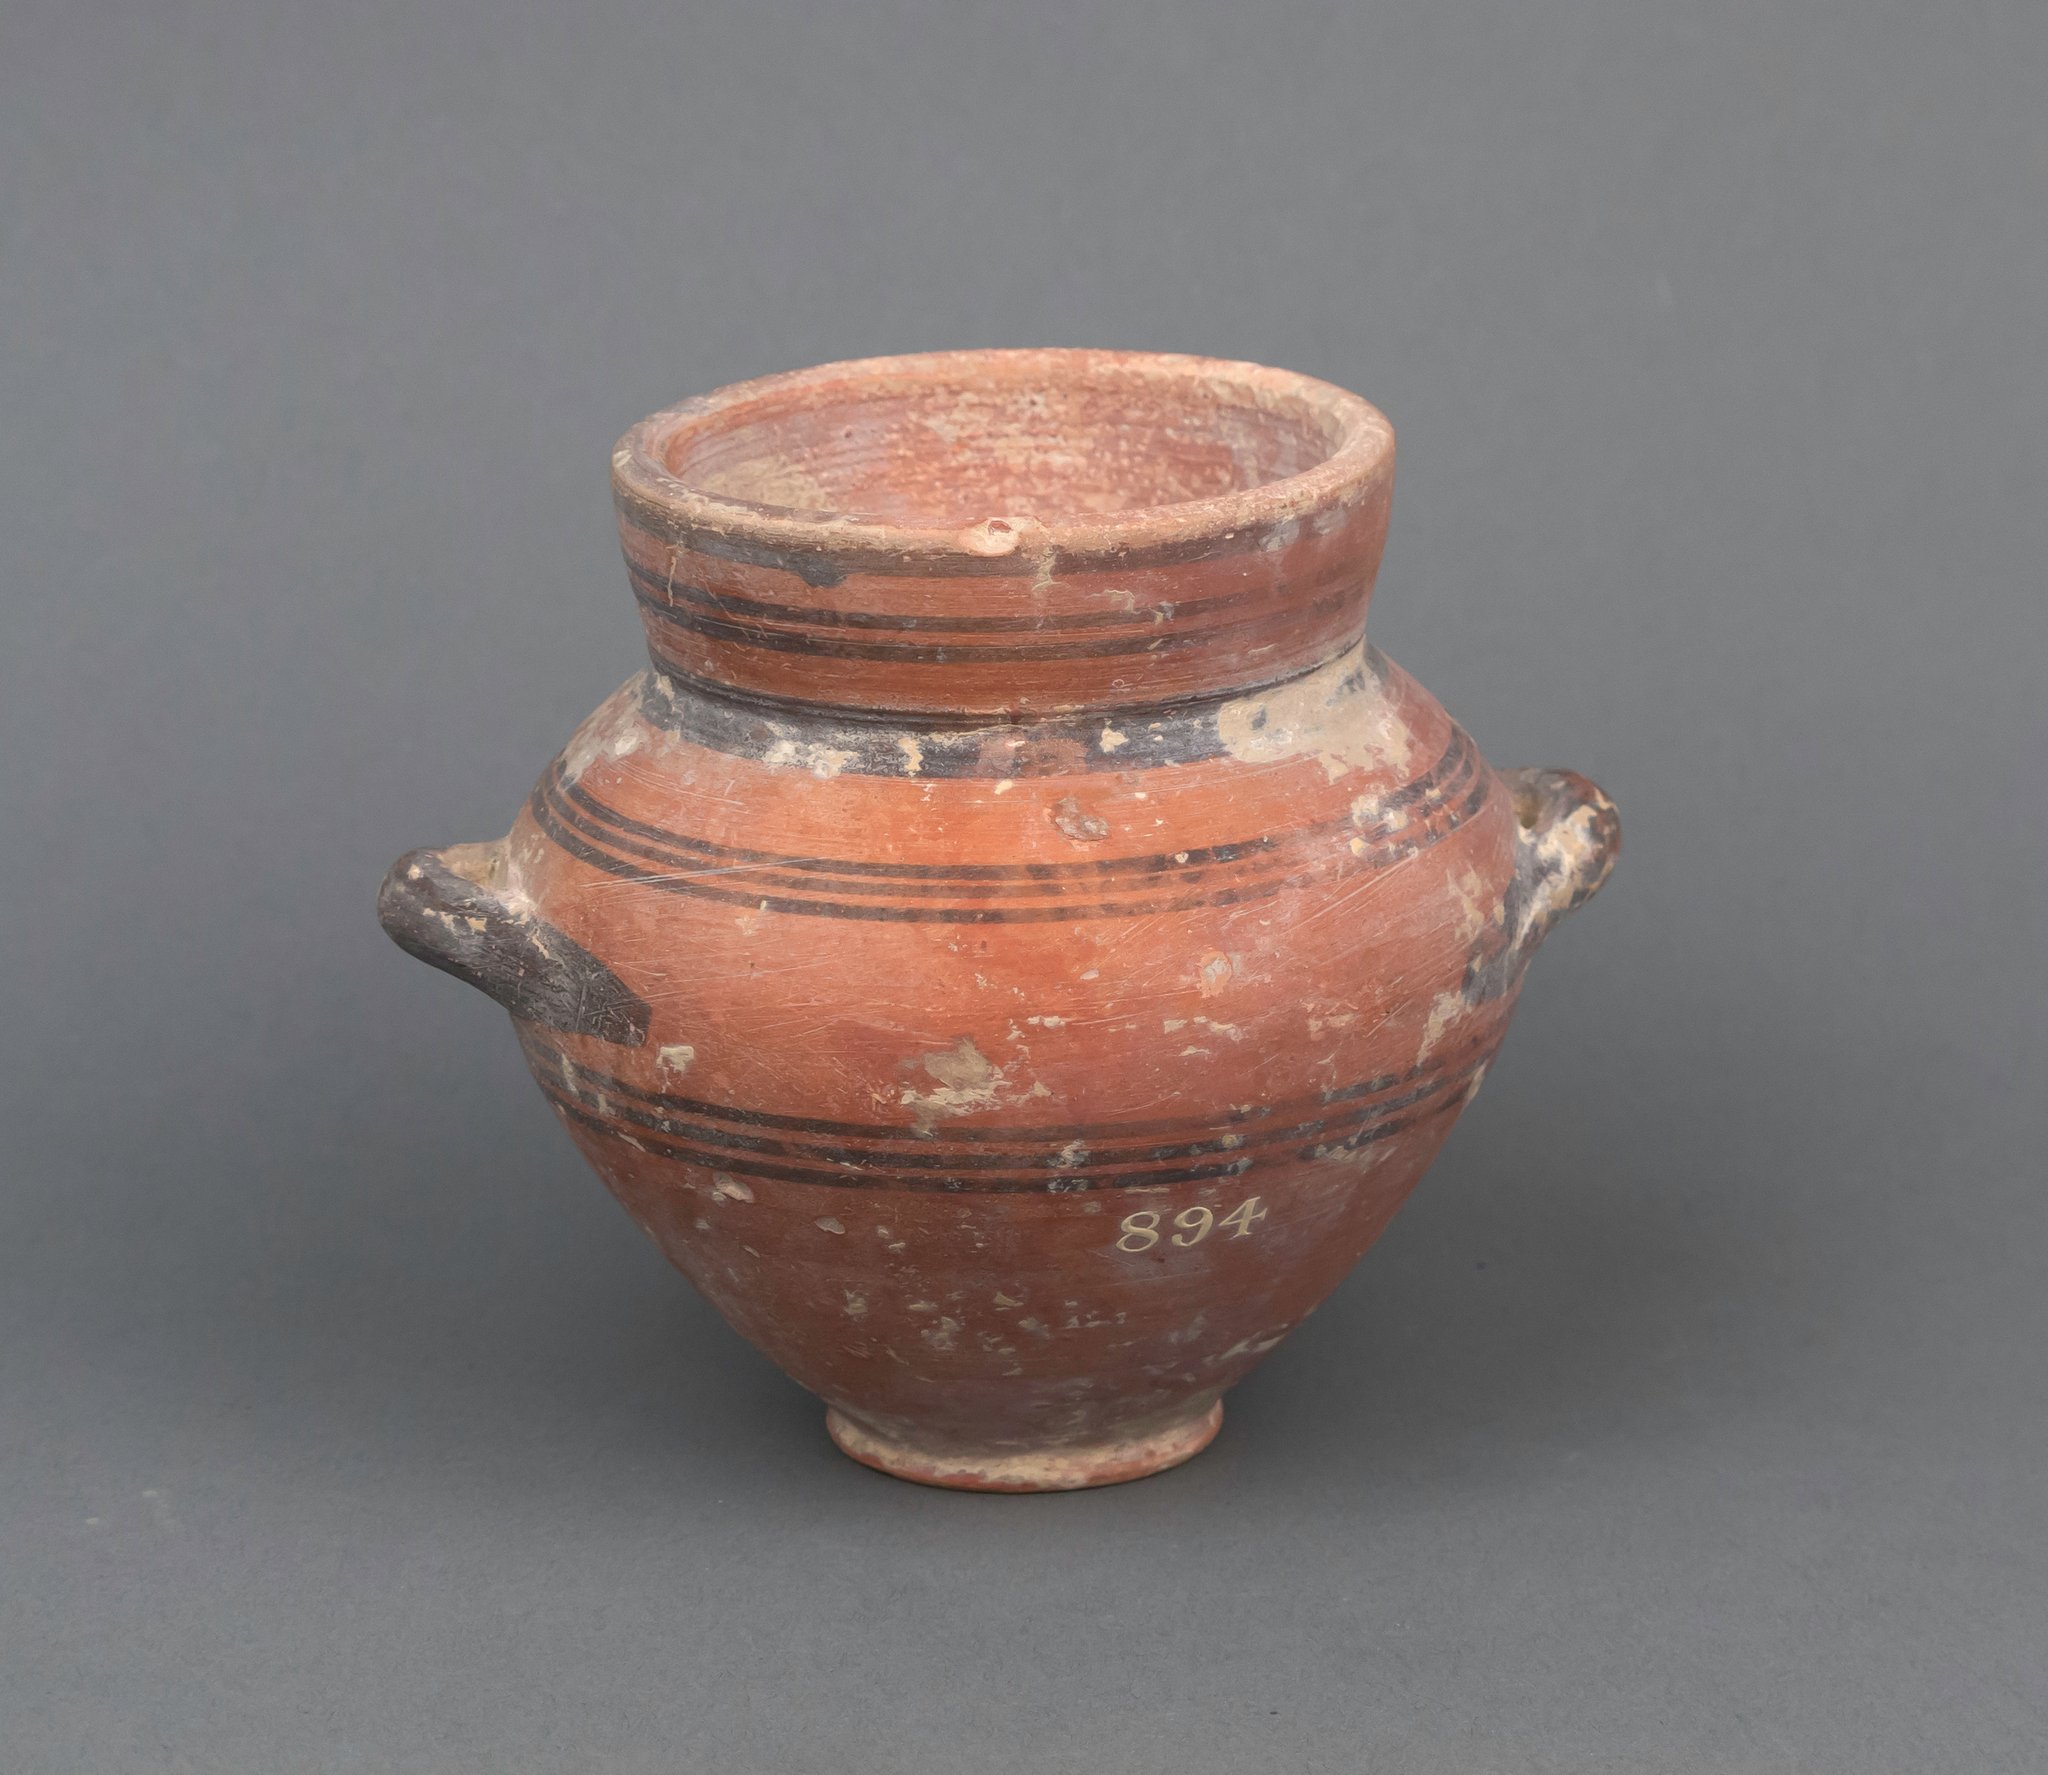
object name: amphoriskos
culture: cypriot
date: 600-480 BCE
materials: terracotta